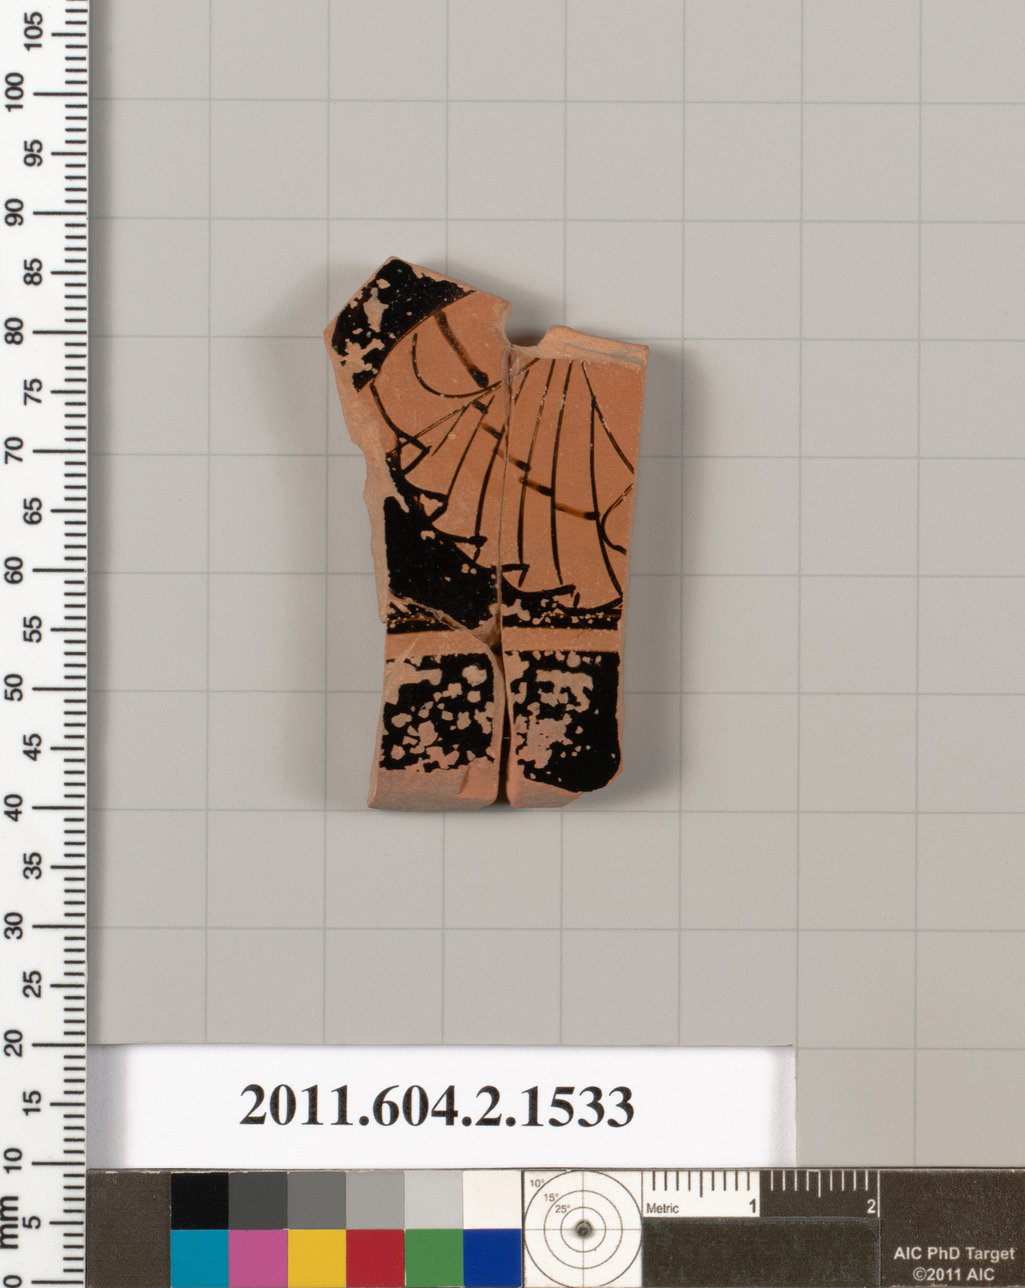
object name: skyphos fragment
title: Terracotta fragment of a skyphos (deep drinking cup)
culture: greek, attic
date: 490-470 BCE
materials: terracotta